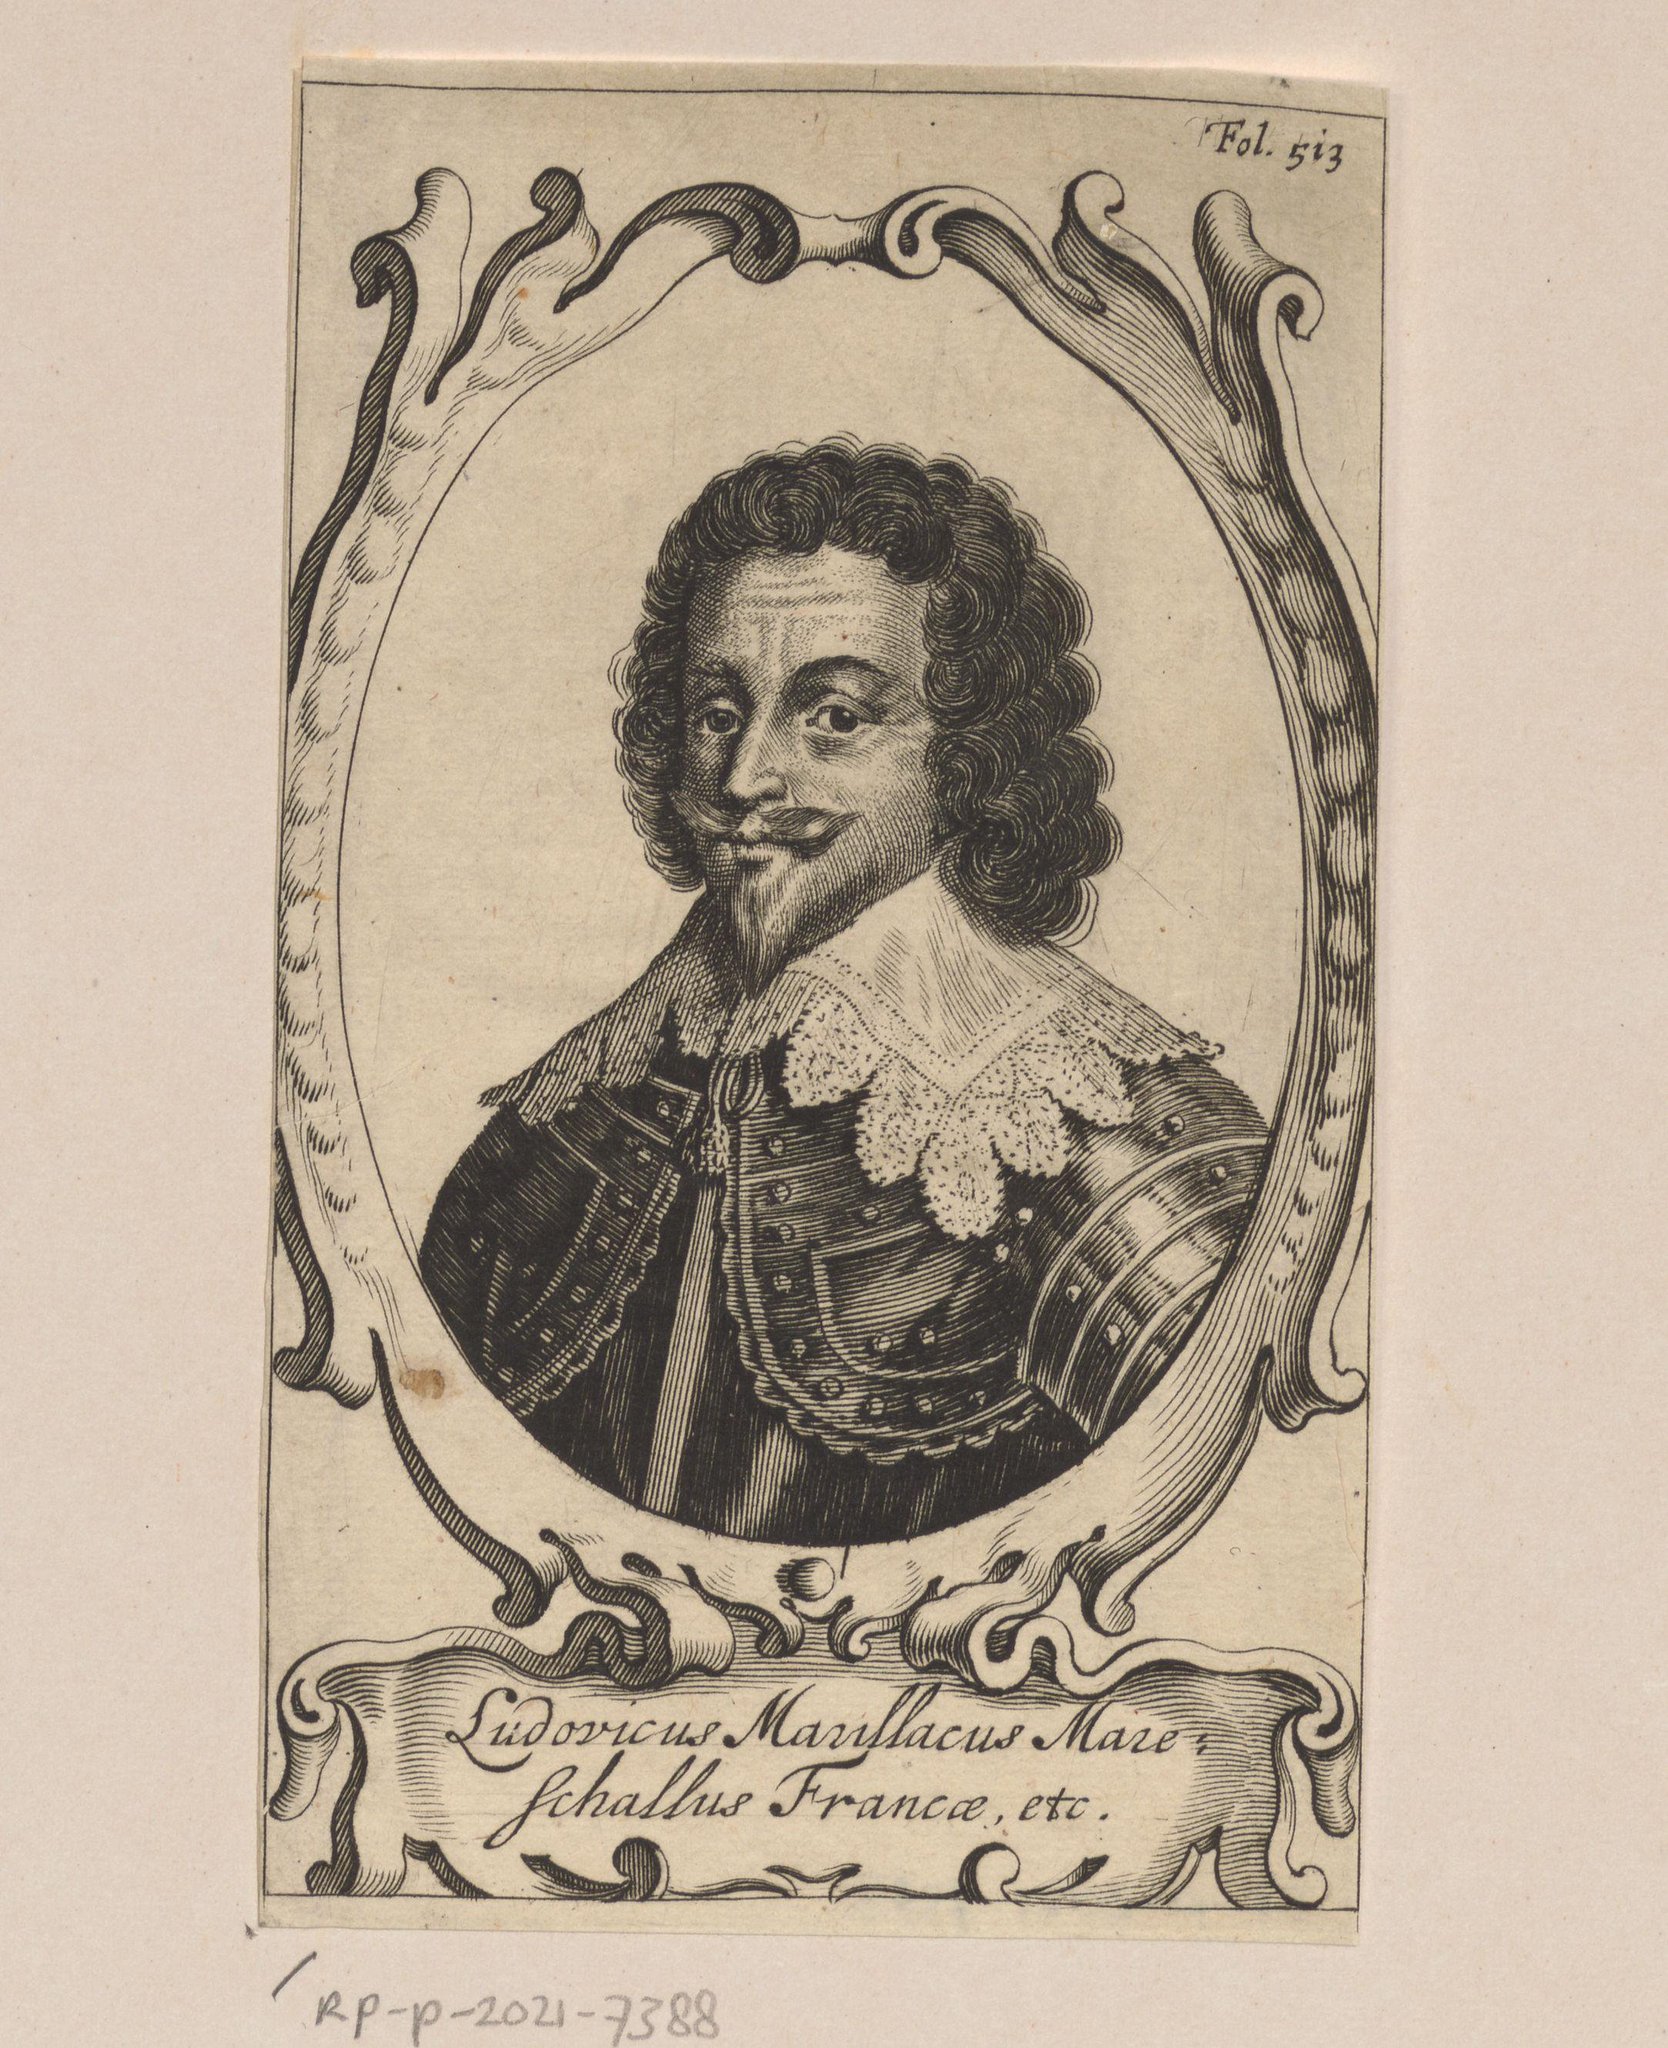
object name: book illustration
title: Portret van Louis de Marillac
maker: Anonymous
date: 1656-1666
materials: paper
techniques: engraving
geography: northern netherlands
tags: earl, rocaille ornament, historical persons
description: Prent waarschijnlijk uit: Brachelius, Johannes Adolphus. Historia nostri temporis, dat is geschiedenis onses tijts (…). Rotterdam: Andries van Hoogenhuysen, 1656. Prent ook gebruikt in de 1659- en 1666-editie.